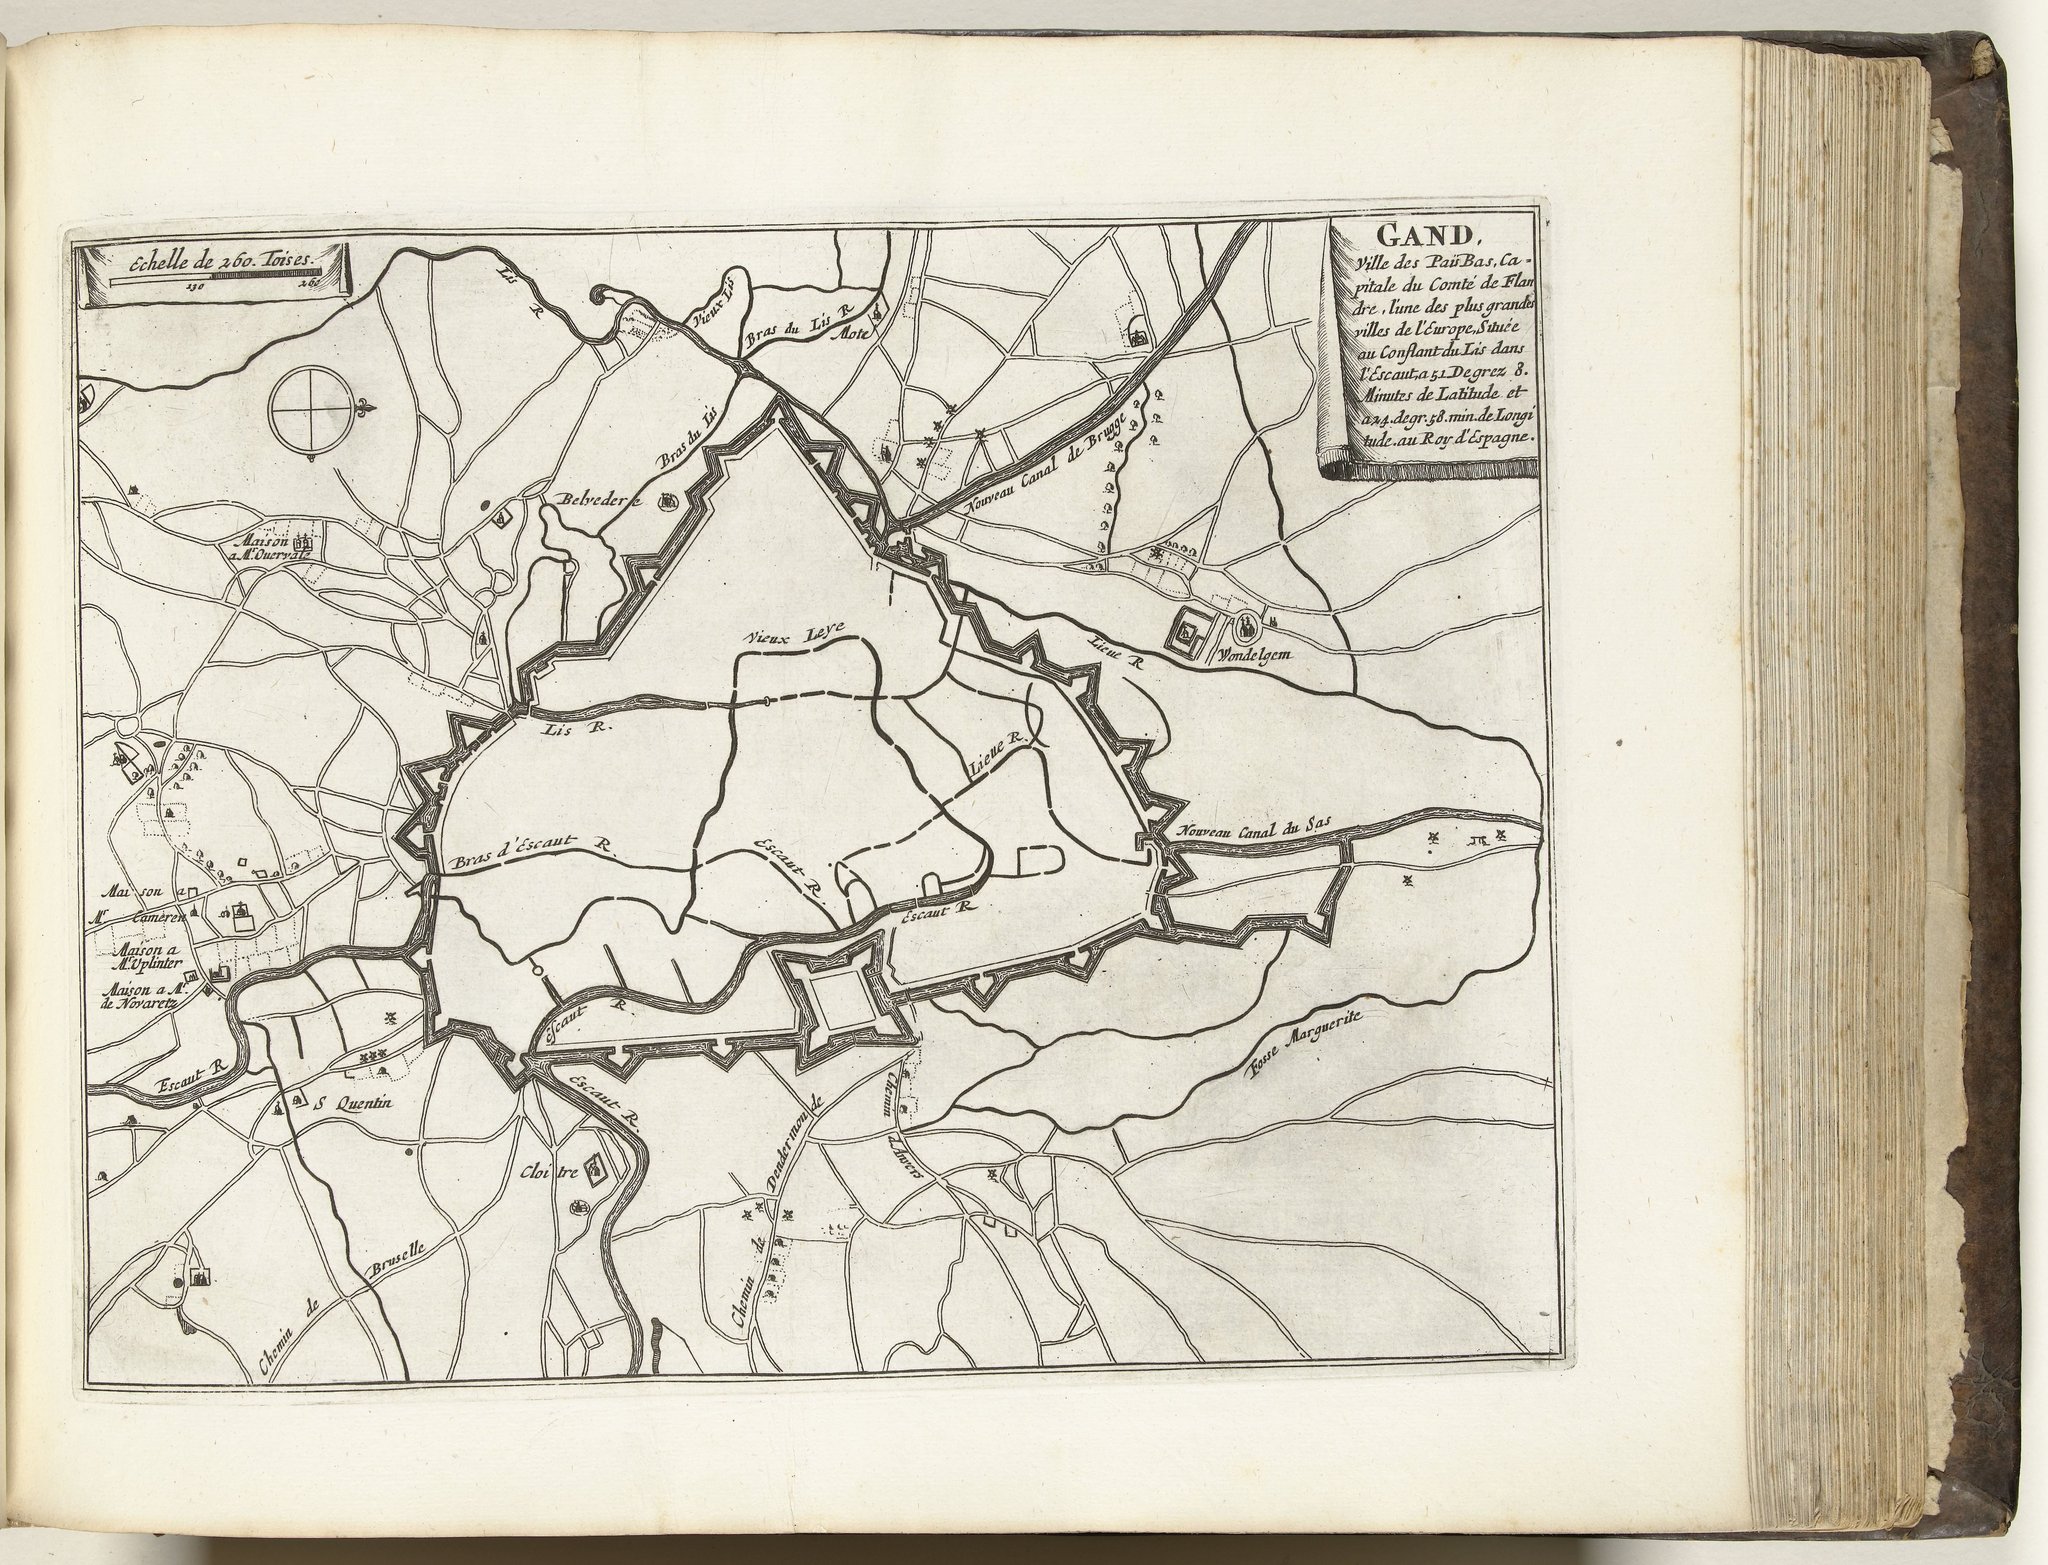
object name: print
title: Gand, Ville des Pais Bas, Capitale du Comté de Flandre (...)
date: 1693-1696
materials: paper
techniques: etching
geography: france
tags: fortress, maps of cities, ghent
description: Plattegrond van de versterkingen om de Vlaamse stad Gent. Onderdeel van het zesde deel (1696) van het prentwerk waarin gebundeld zijn de acht delen van Les forces de l'Europe uitgegeven tussen 1693-1697. Het prentwerk bestaat uit 175 platen met plannen (afkomstig van Sébastien Le Prestre, Seigneur de Vauban) van vermaarde sterke steden en vestingen in de Negenjarige Oorlog. Titel en opschriften in het Frans.